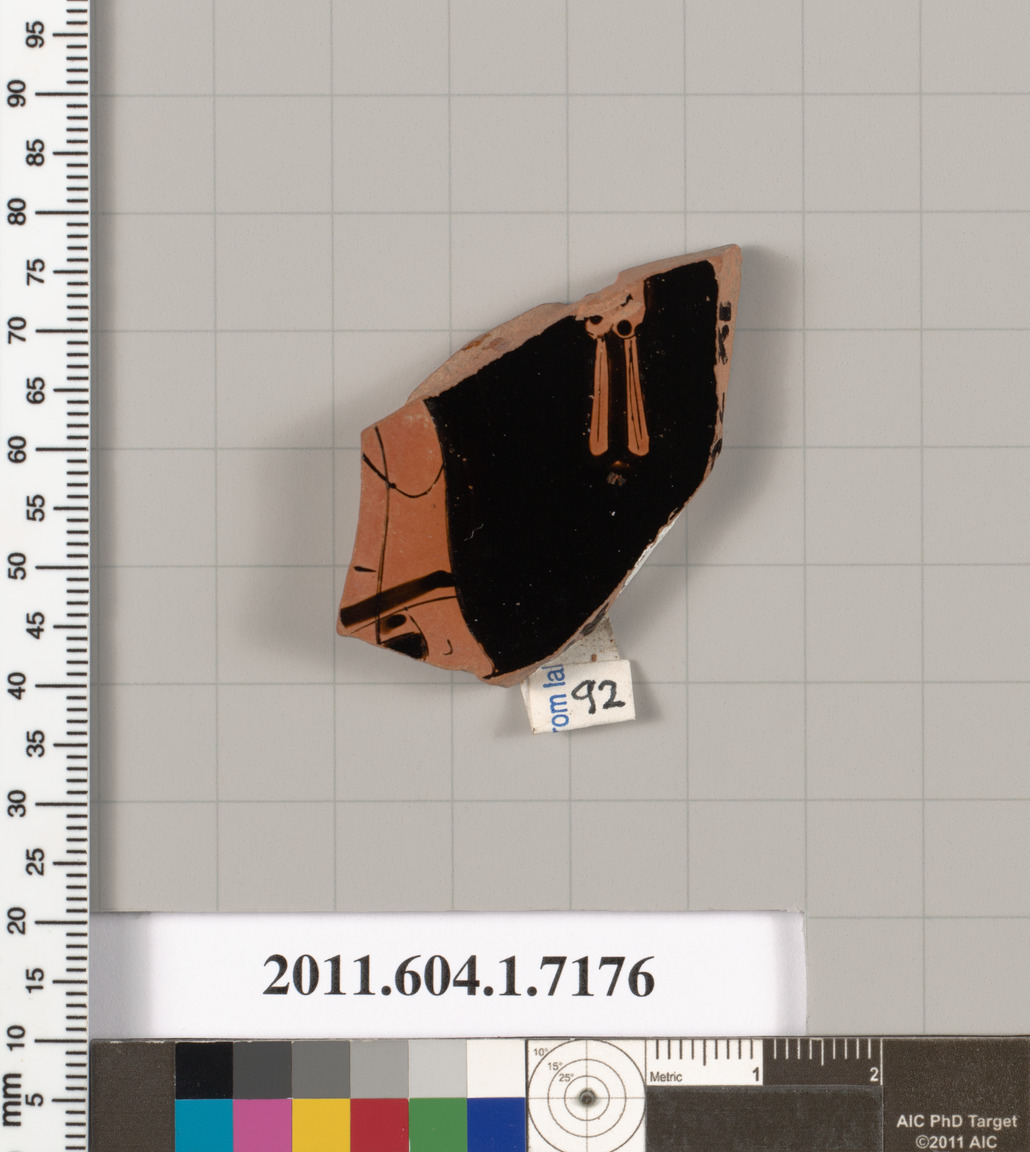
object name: kylix fragment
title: Terracotta fragment of a kylix (drinking cup)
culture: greek, attic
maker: makron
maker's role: artist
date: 500-480 BCE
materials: terracotta